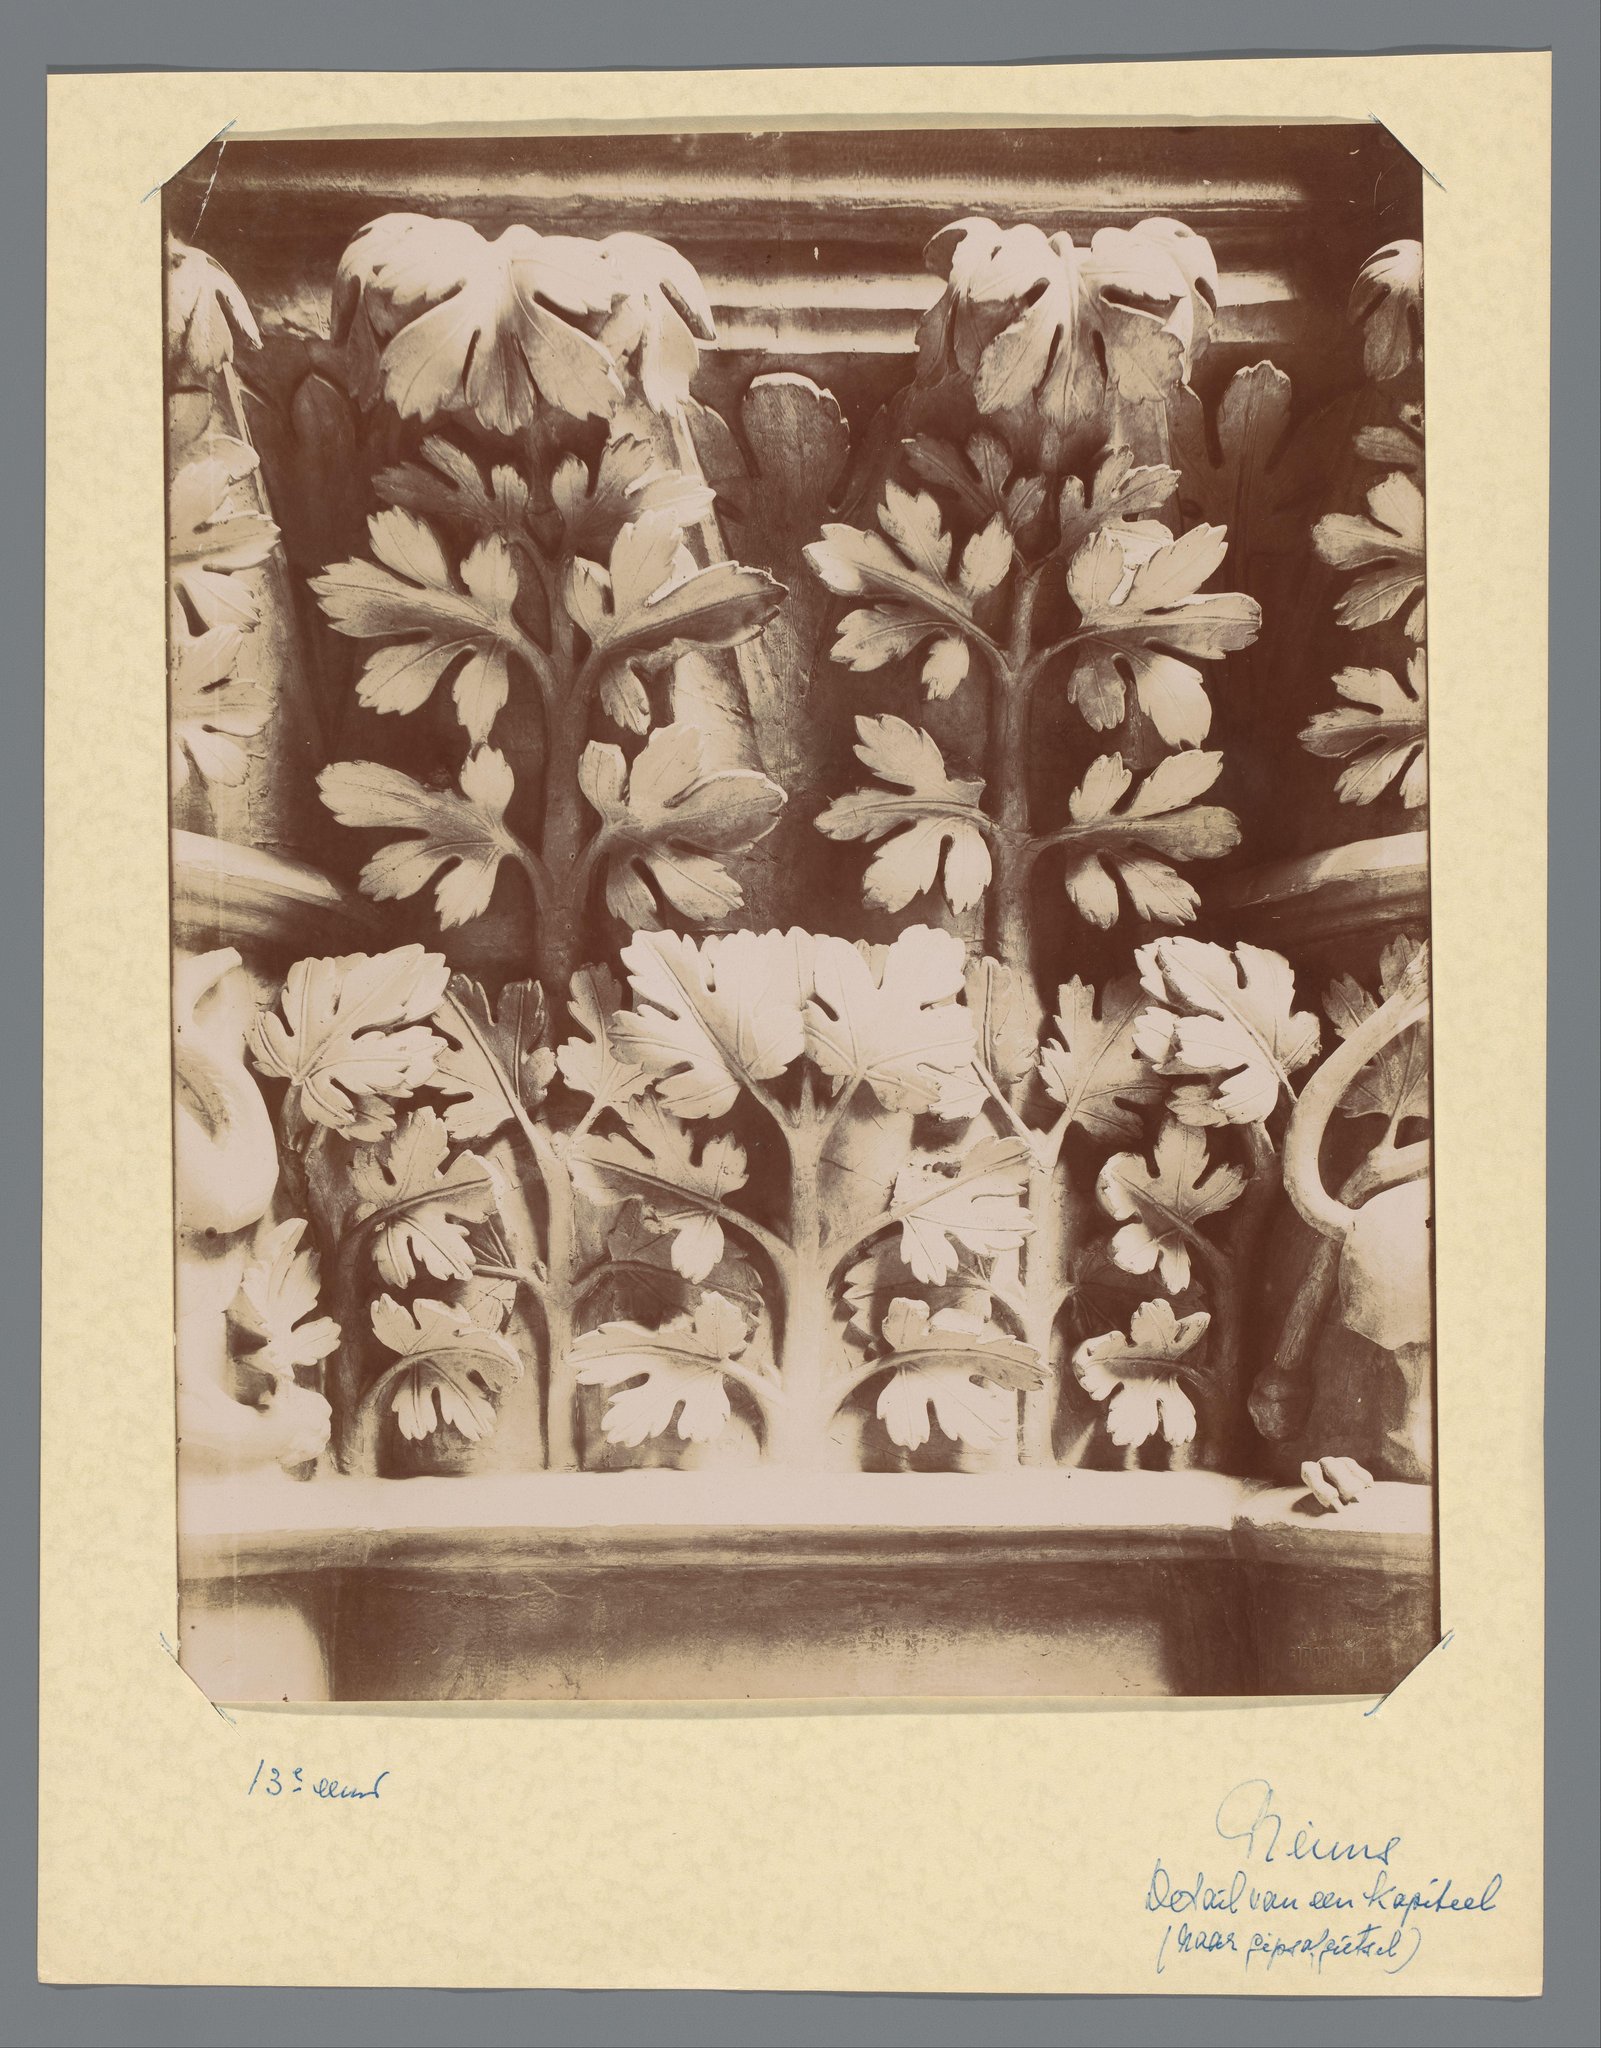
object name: photograph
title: Reims Cathedral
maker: Anonymous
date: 1870-1900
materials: photographic support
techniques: gelatin silver print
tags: kathedraal van reims